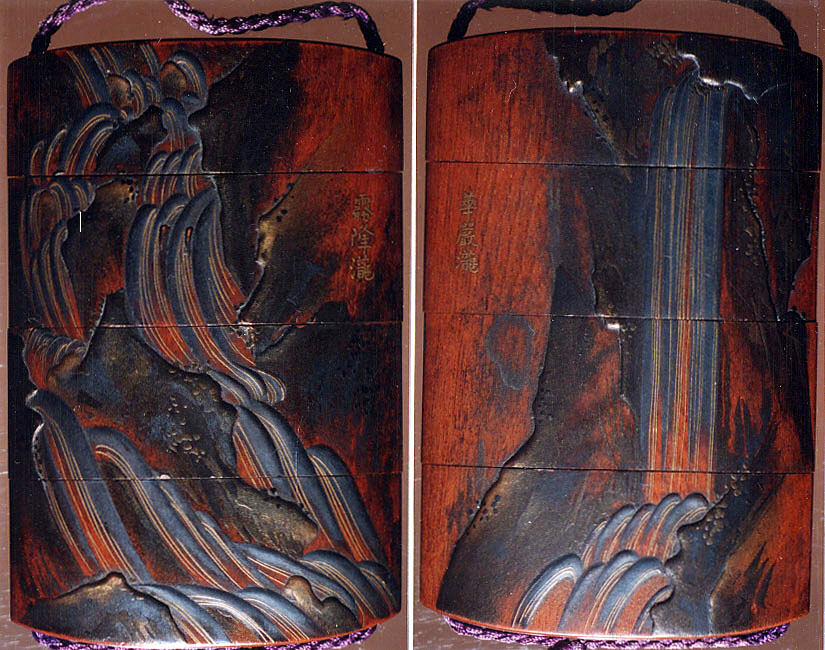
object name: inrō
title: Case (Inrō) with Design of Waterfalls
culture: japanese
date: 1801-1900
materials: gold, lacquer, silver, wood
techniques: hiramakie, maki-e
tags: waterfalls